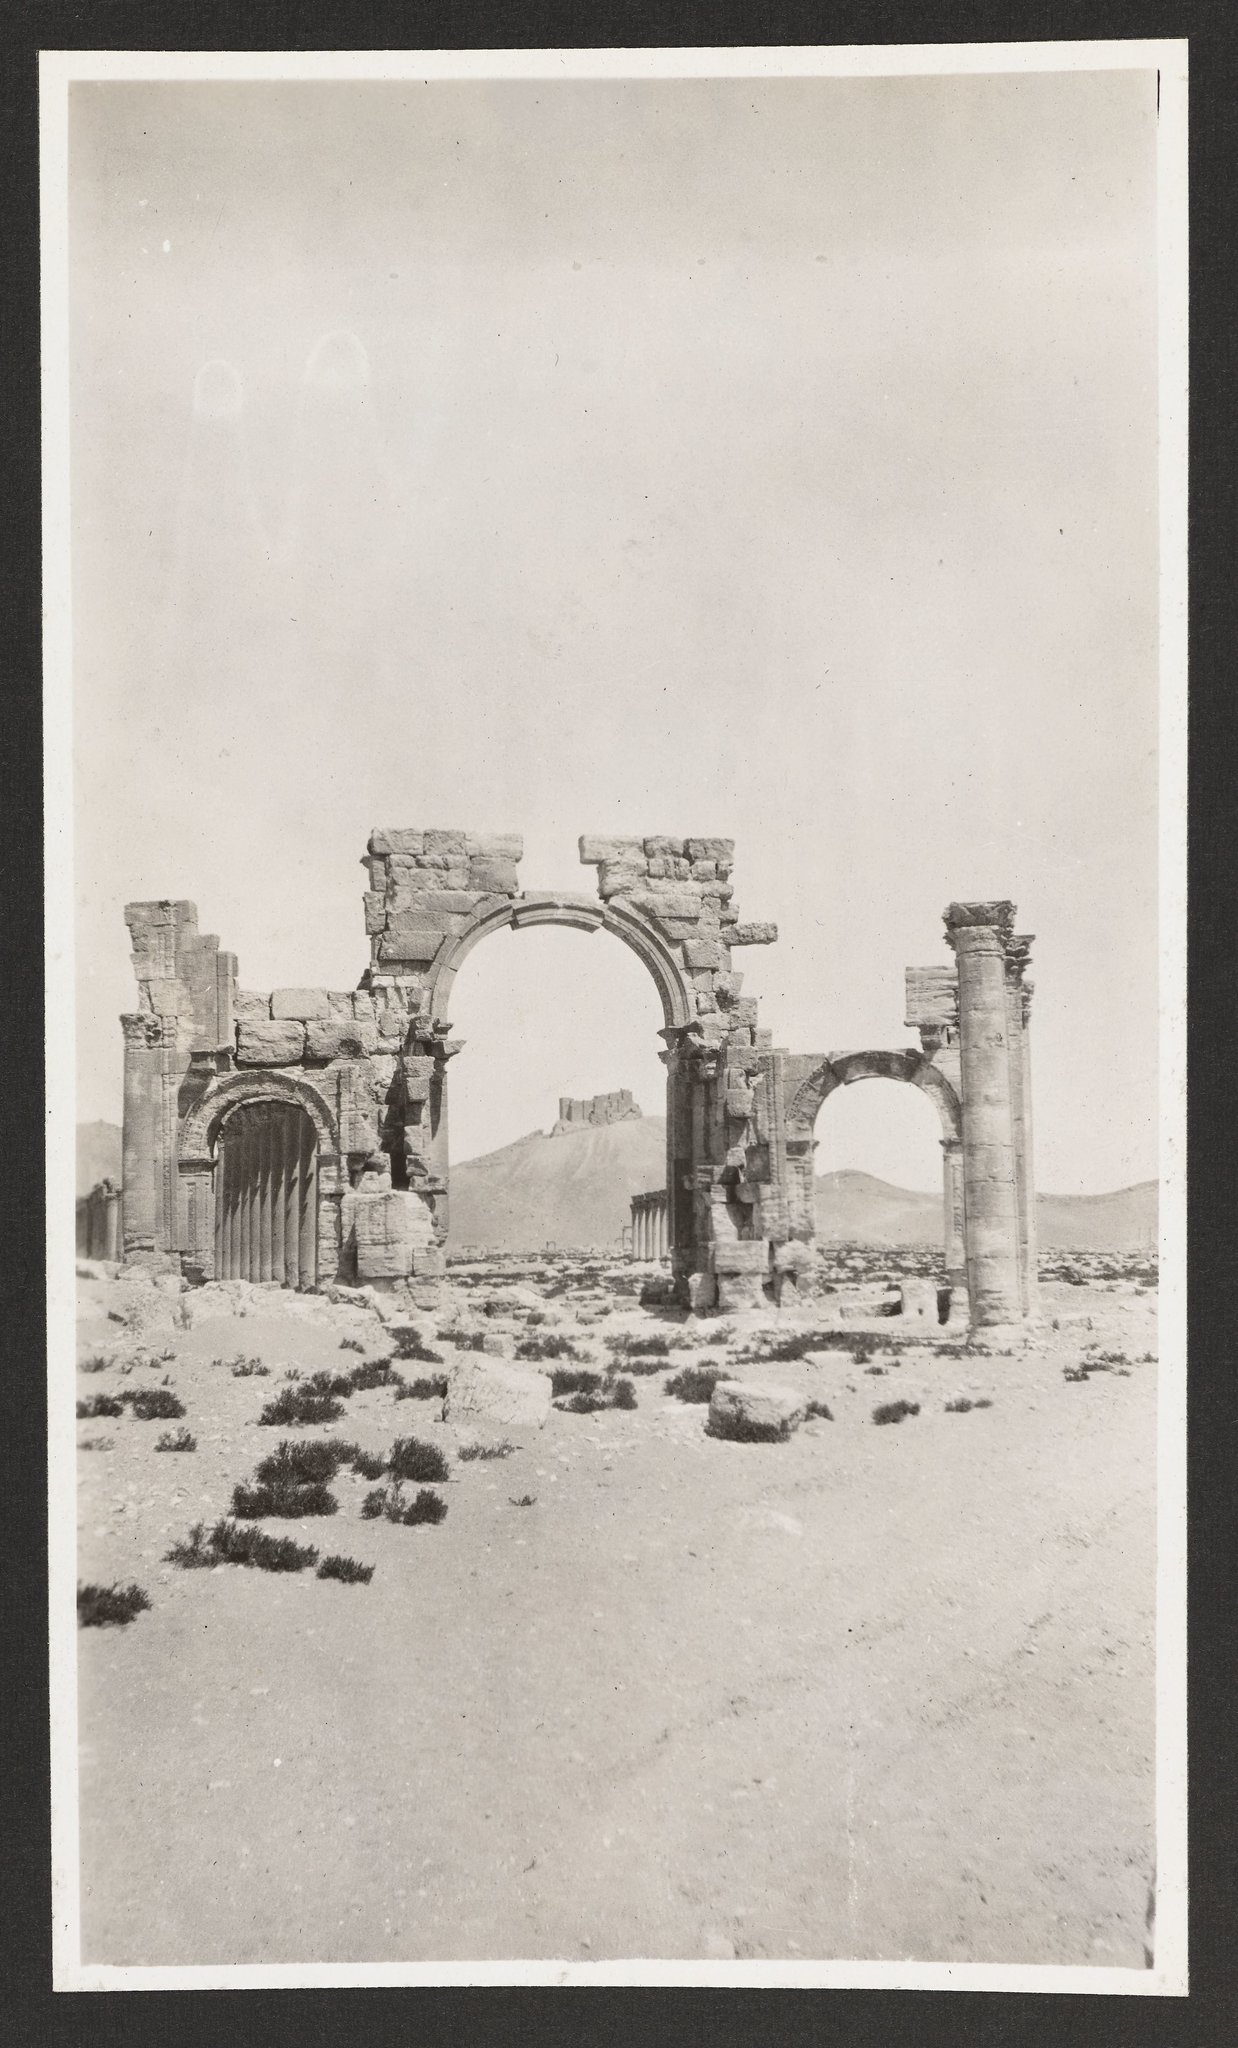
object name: photograph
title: Ruïne van de ingang van de voornaamste zuilenstraat bij Palmyra, Syrië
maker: a.g.a. van eelde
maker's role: engineer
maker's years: 1862-1950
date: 1925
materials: cardboard, paper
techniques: gelatin silver print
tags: syrië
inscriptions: number: ‘4.’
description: Titel op object afkomstig uit inventaris (Verklaring der Photo's) behorend bij het album.